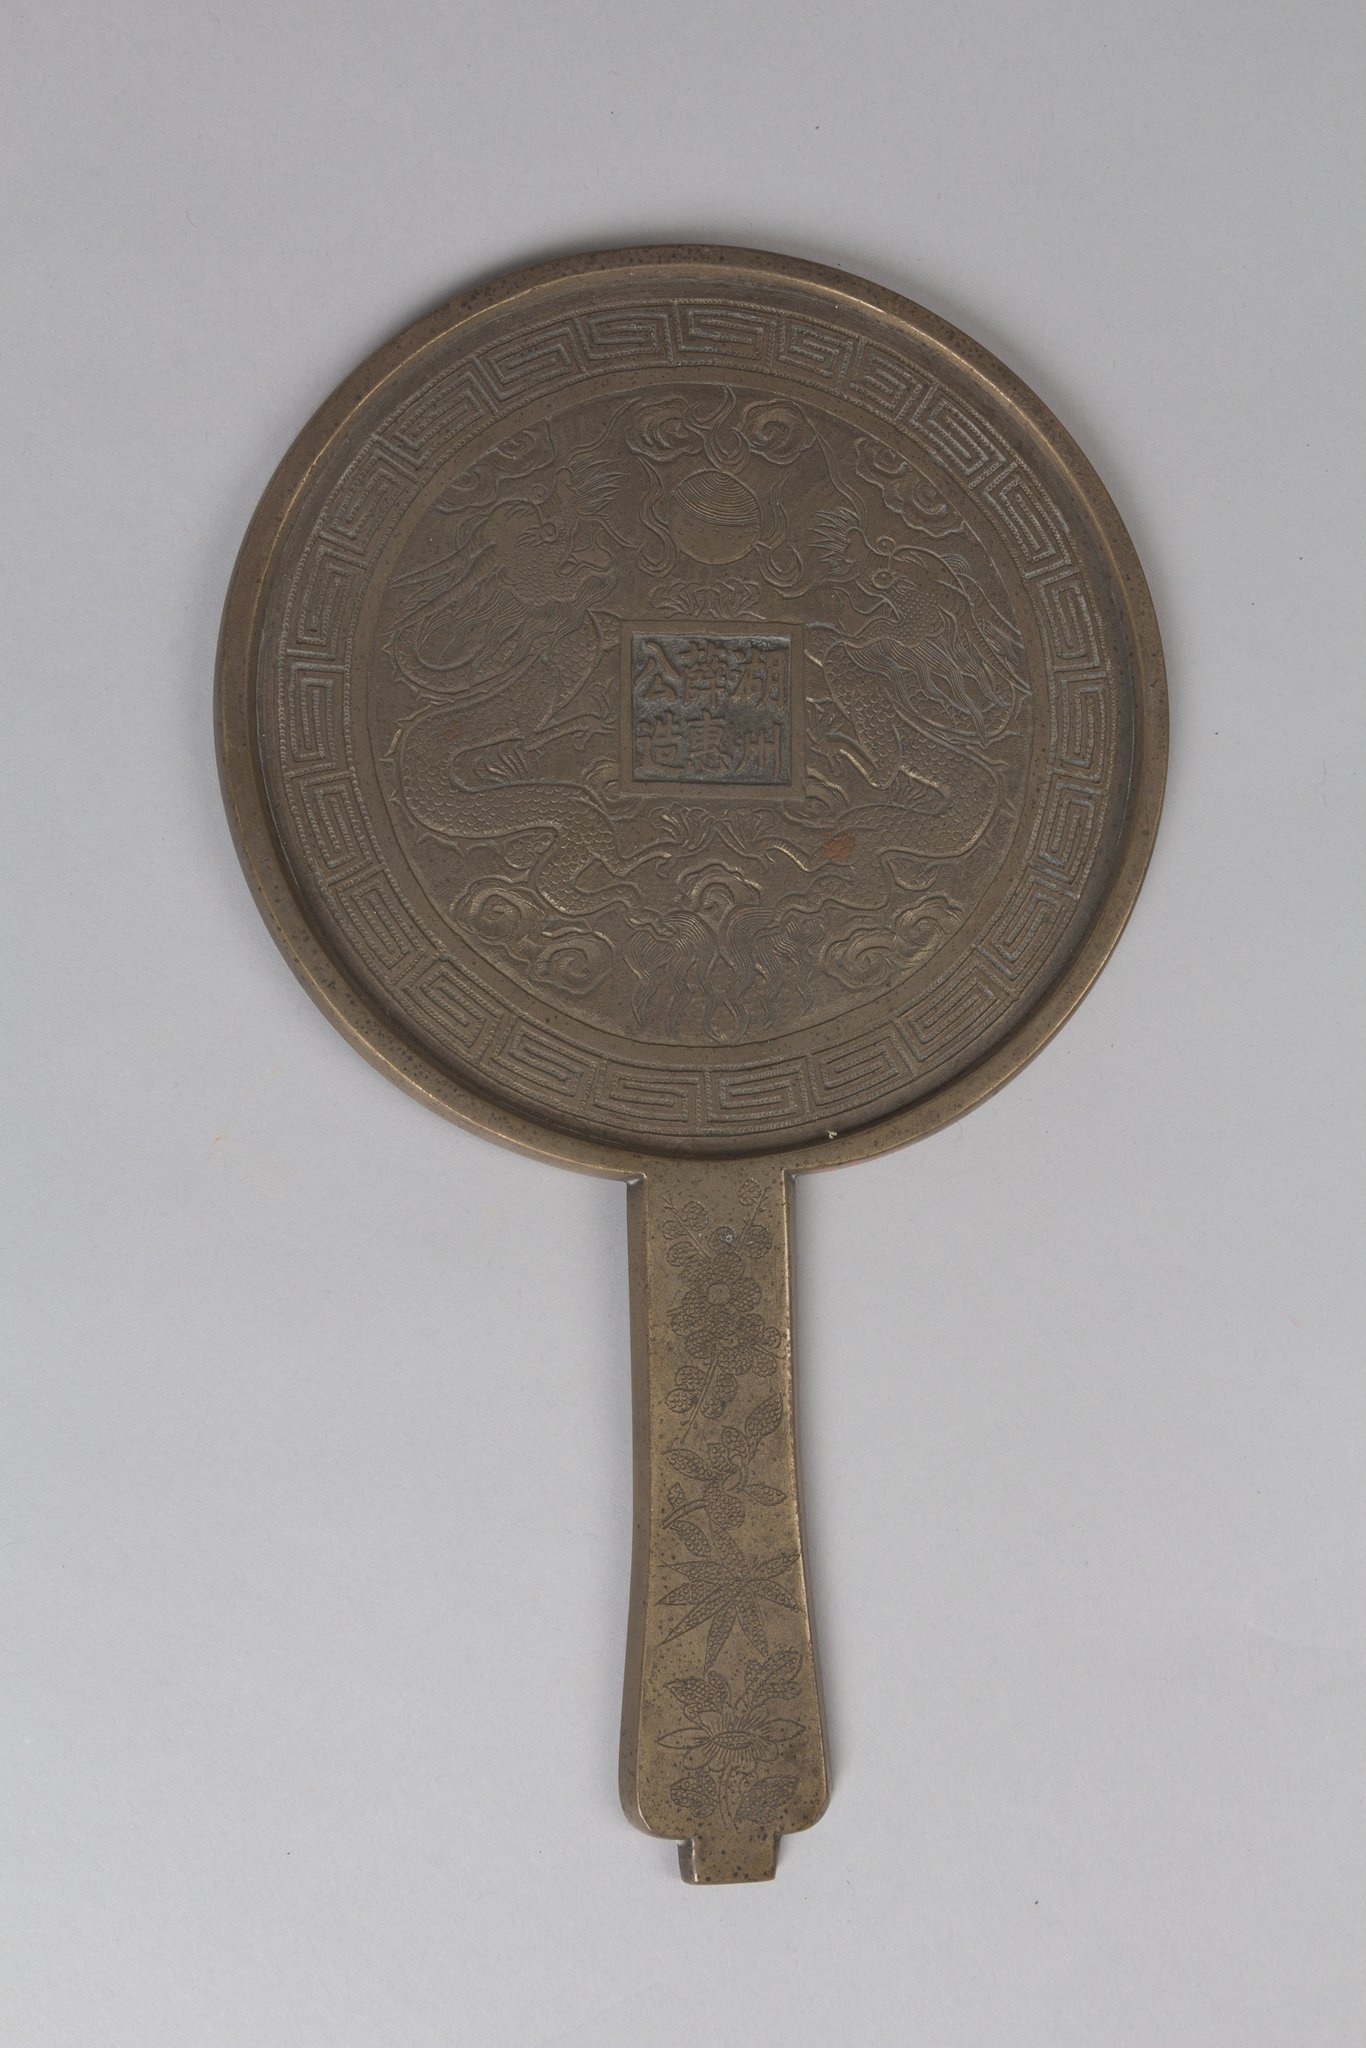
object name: mirror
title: Mirror with handle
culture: chinese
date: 1701-1800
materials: brass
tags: dragons